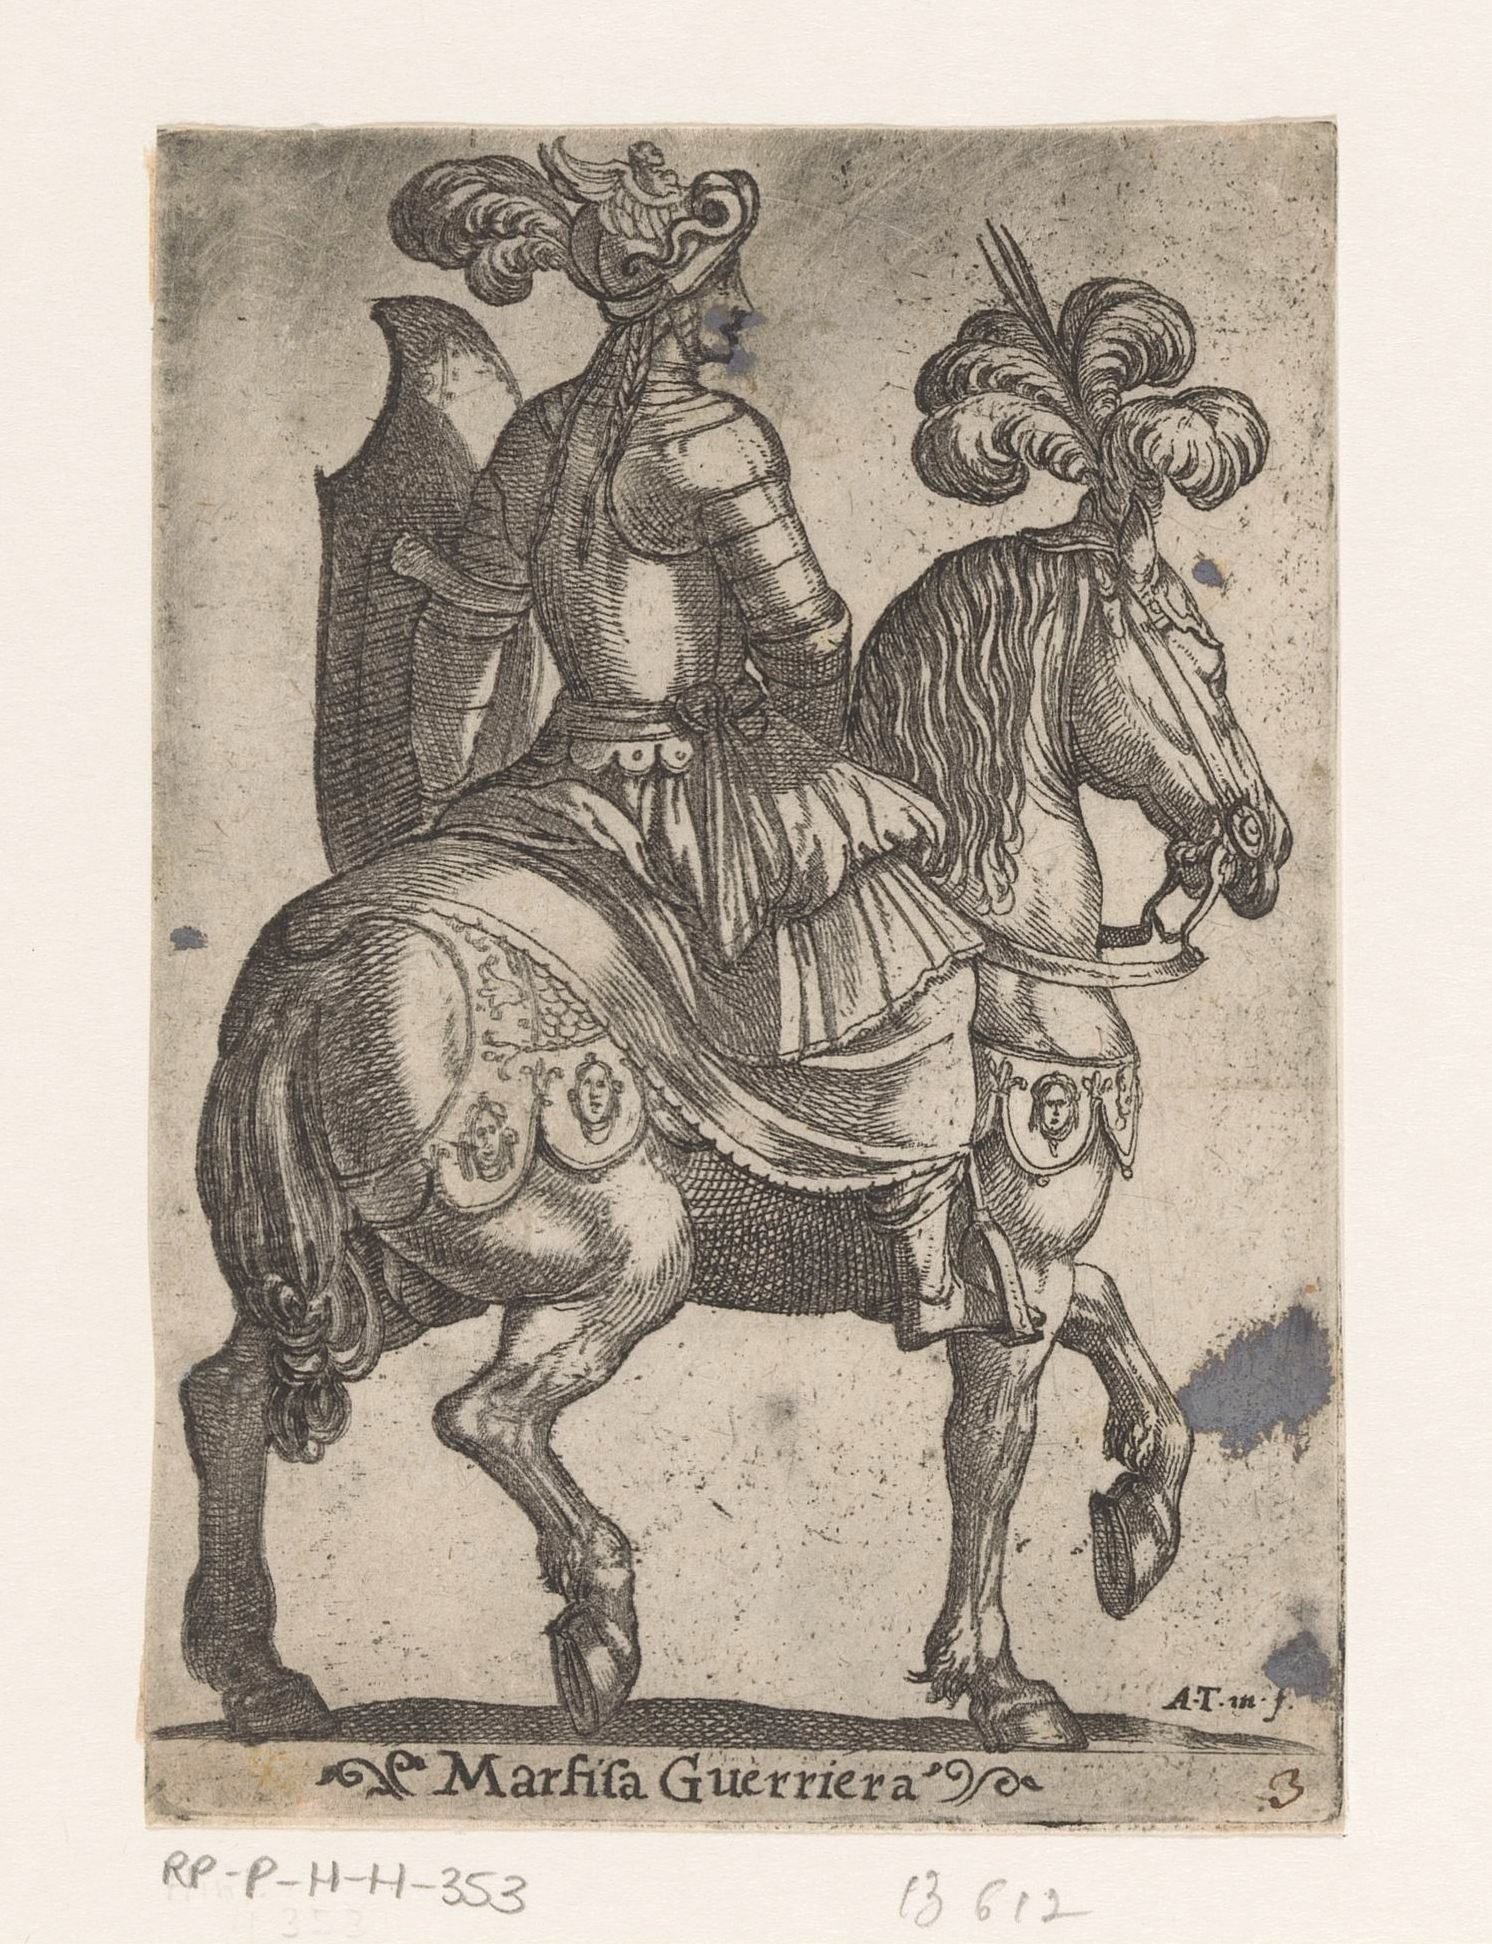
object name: print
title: Marfisa Gurriera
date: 1597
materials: paper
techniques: etching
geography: italy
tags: (scenes from) specific works of literature: ariosto, orlando furioso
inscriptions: number: ‘3’, collector's mark: ‘Hinloopen’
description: Deze prent maakt deel uit van een reeks van 8 prenten. Op het verso een licht afzetsel van de prent met Rinaldo uit dezelfde serie.